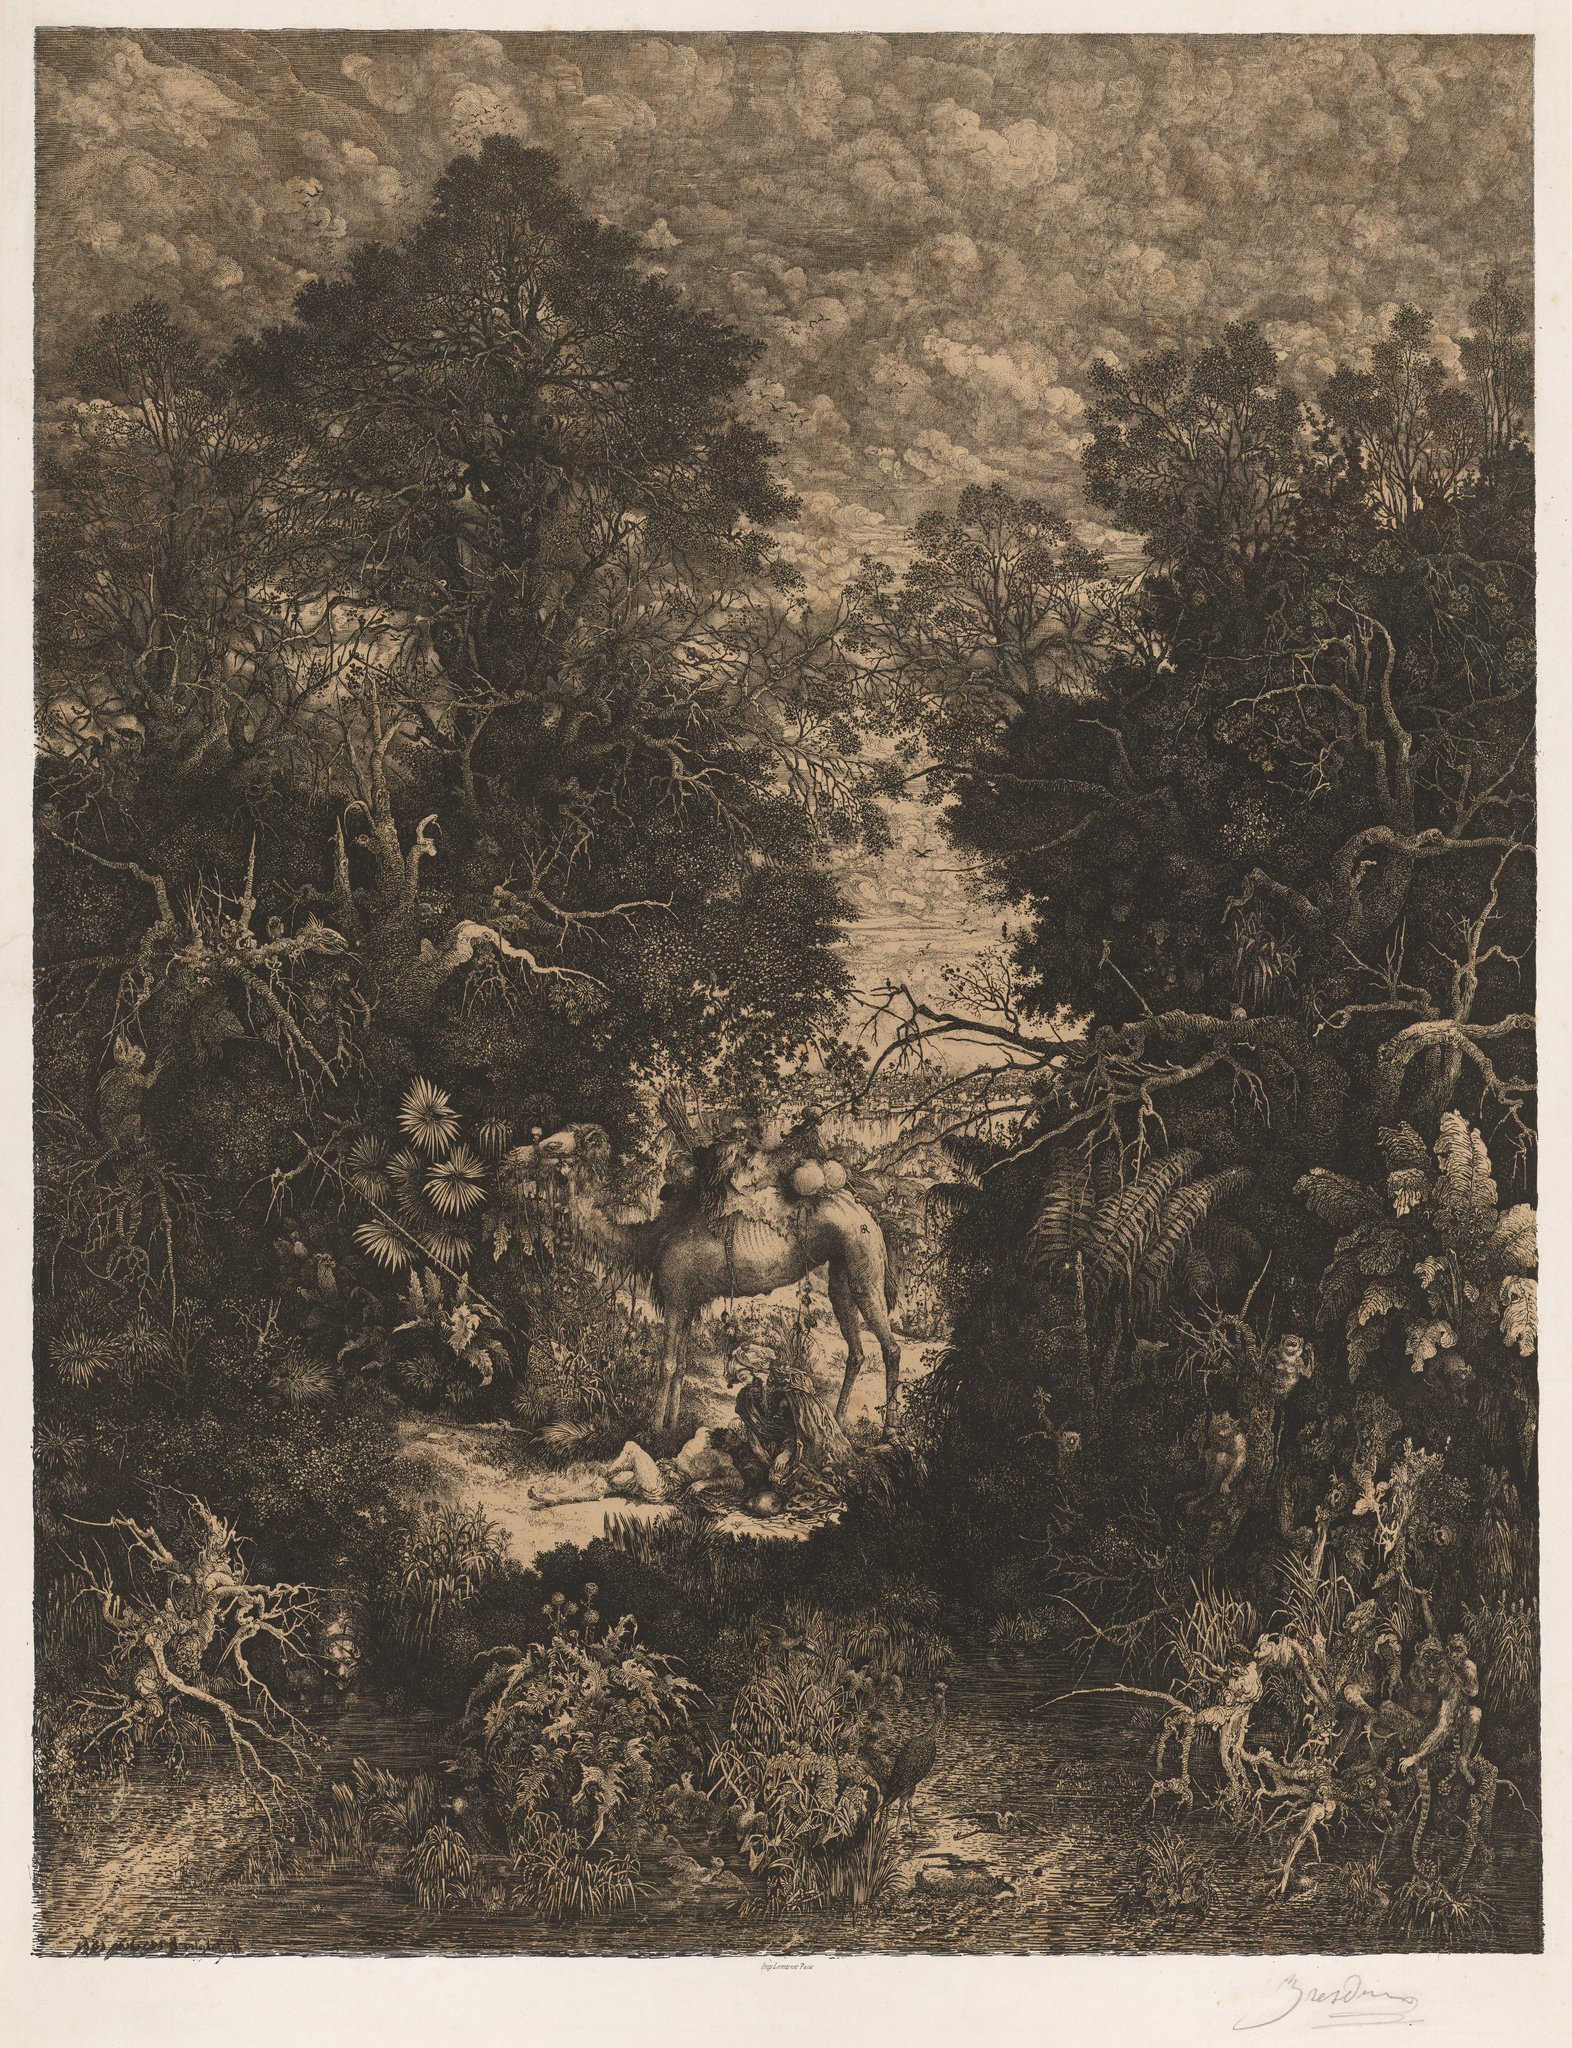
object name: print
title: The Good Samaritan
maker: rodolphe bresdin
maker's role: artist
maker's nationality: french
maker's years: 1822-1885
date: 1861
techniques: lithograph